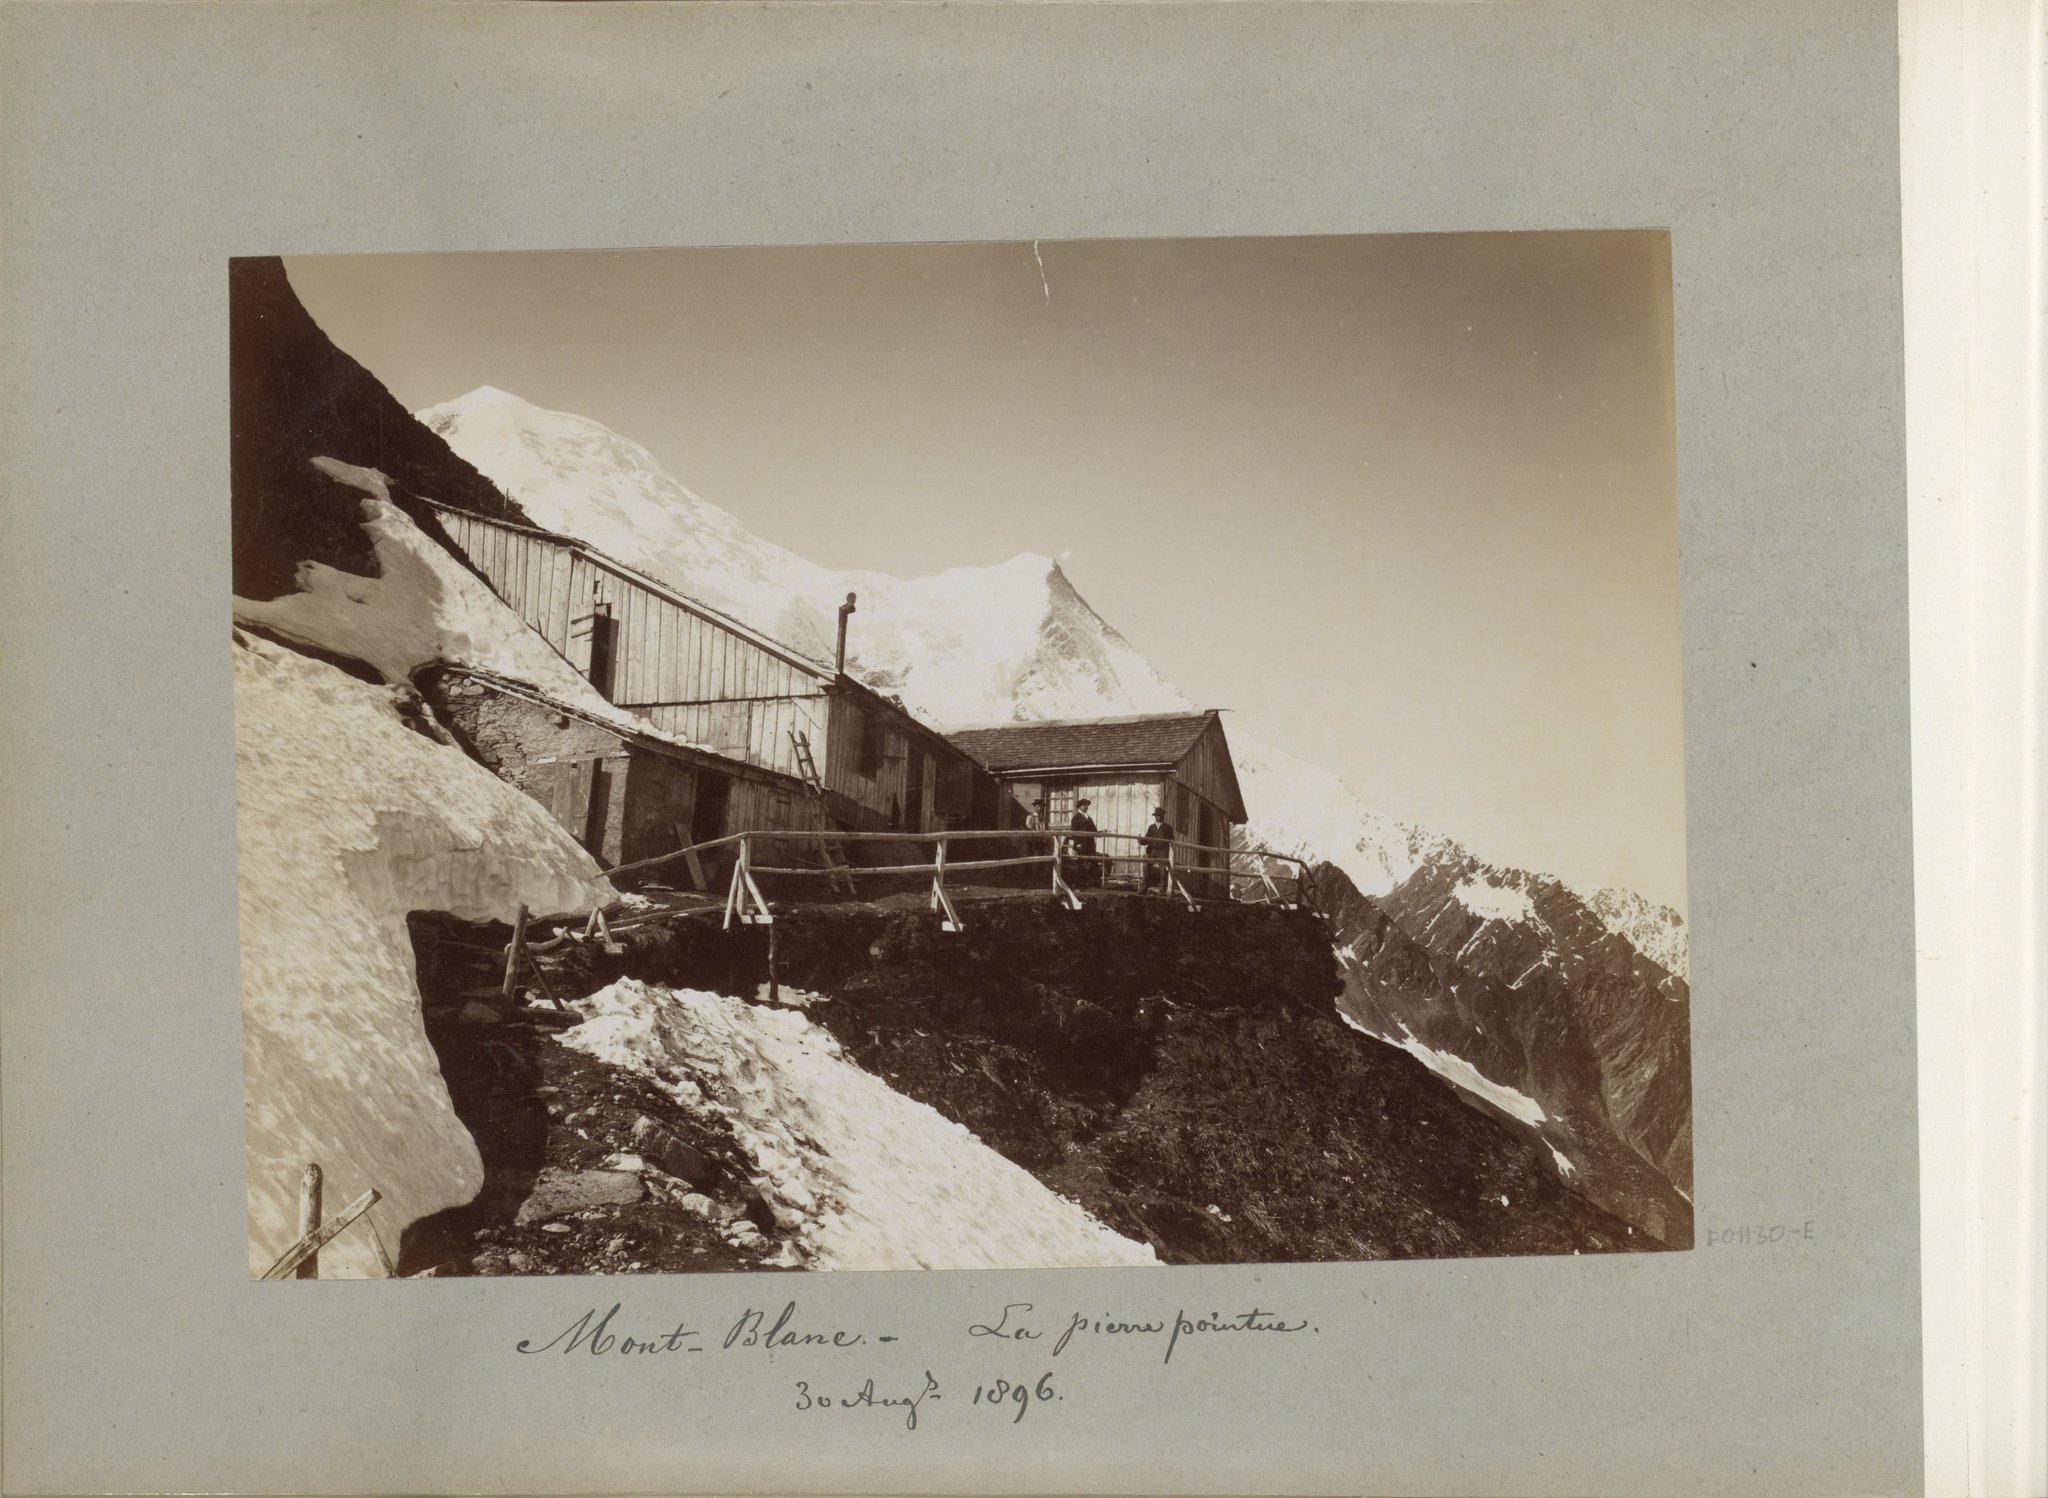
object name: album leaf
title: Bezoekers bij berghut Pierre Pointue op de Mont Blanc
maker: Anonymous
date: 1880-1896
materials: paper, photographic support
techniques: albumen print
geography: mont blanc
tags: mountain-range, snow peaks, hut, cabin, lodge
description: Onderdeel van Reisalbum met foto's van bezienswaardigheden in Frankrijk, Spanje, Italië, Duitsland, Zwitserland en Oostenrijk.